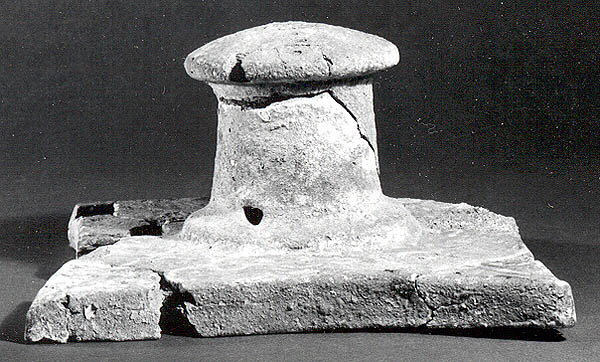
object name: wall plaque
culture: iranian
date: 900-801 BCE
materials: ceramic, glaze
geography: iran